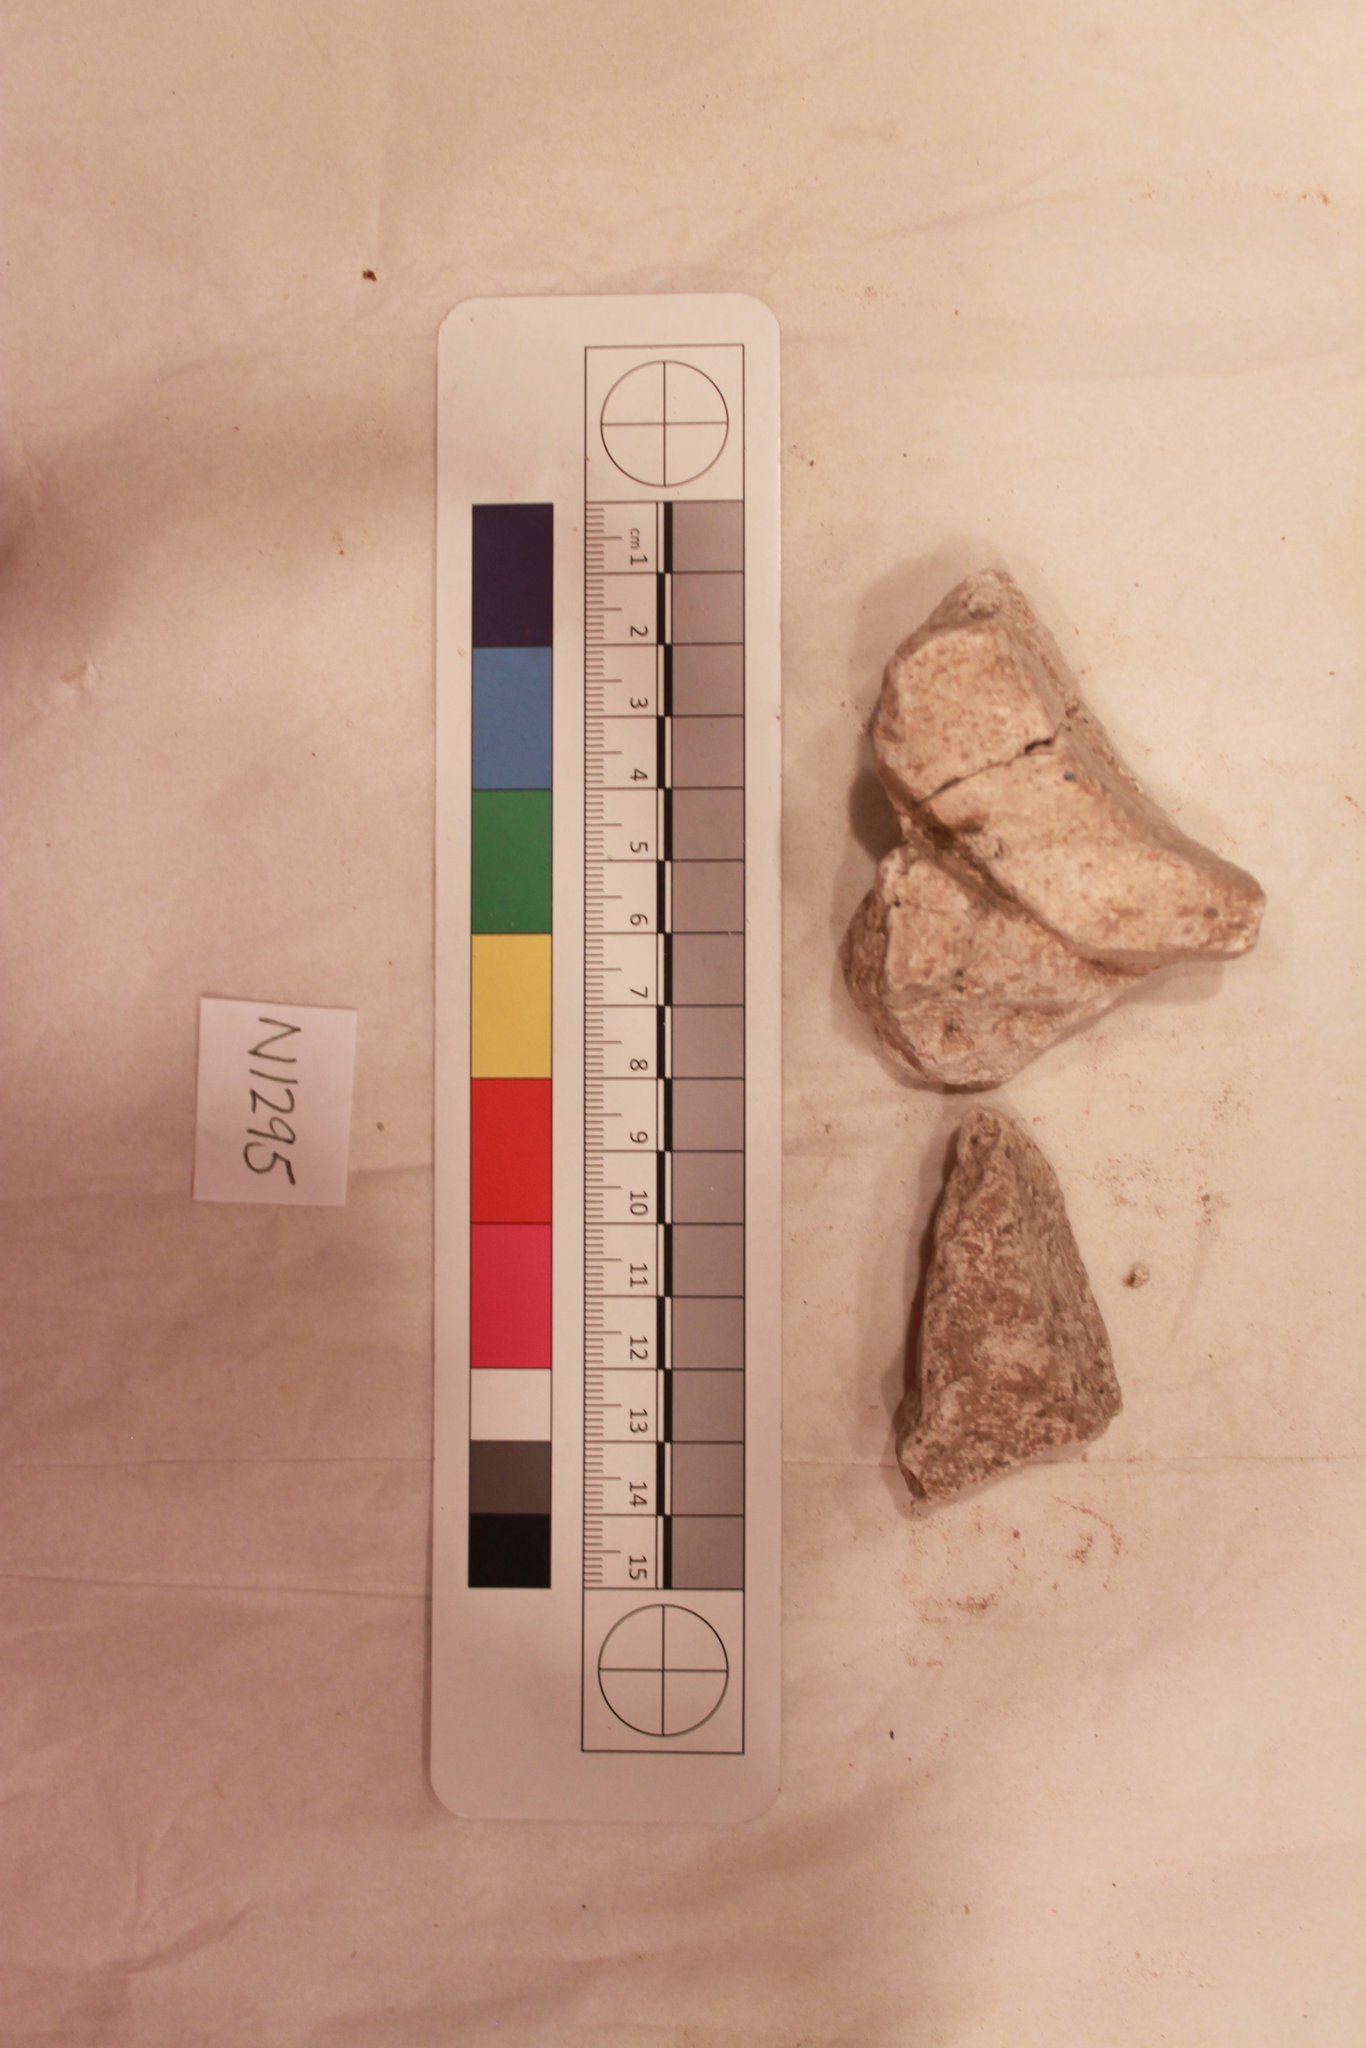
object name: fragment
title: Stucco Fragment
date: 701-1200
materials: plaster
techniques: carving, painting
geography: iran